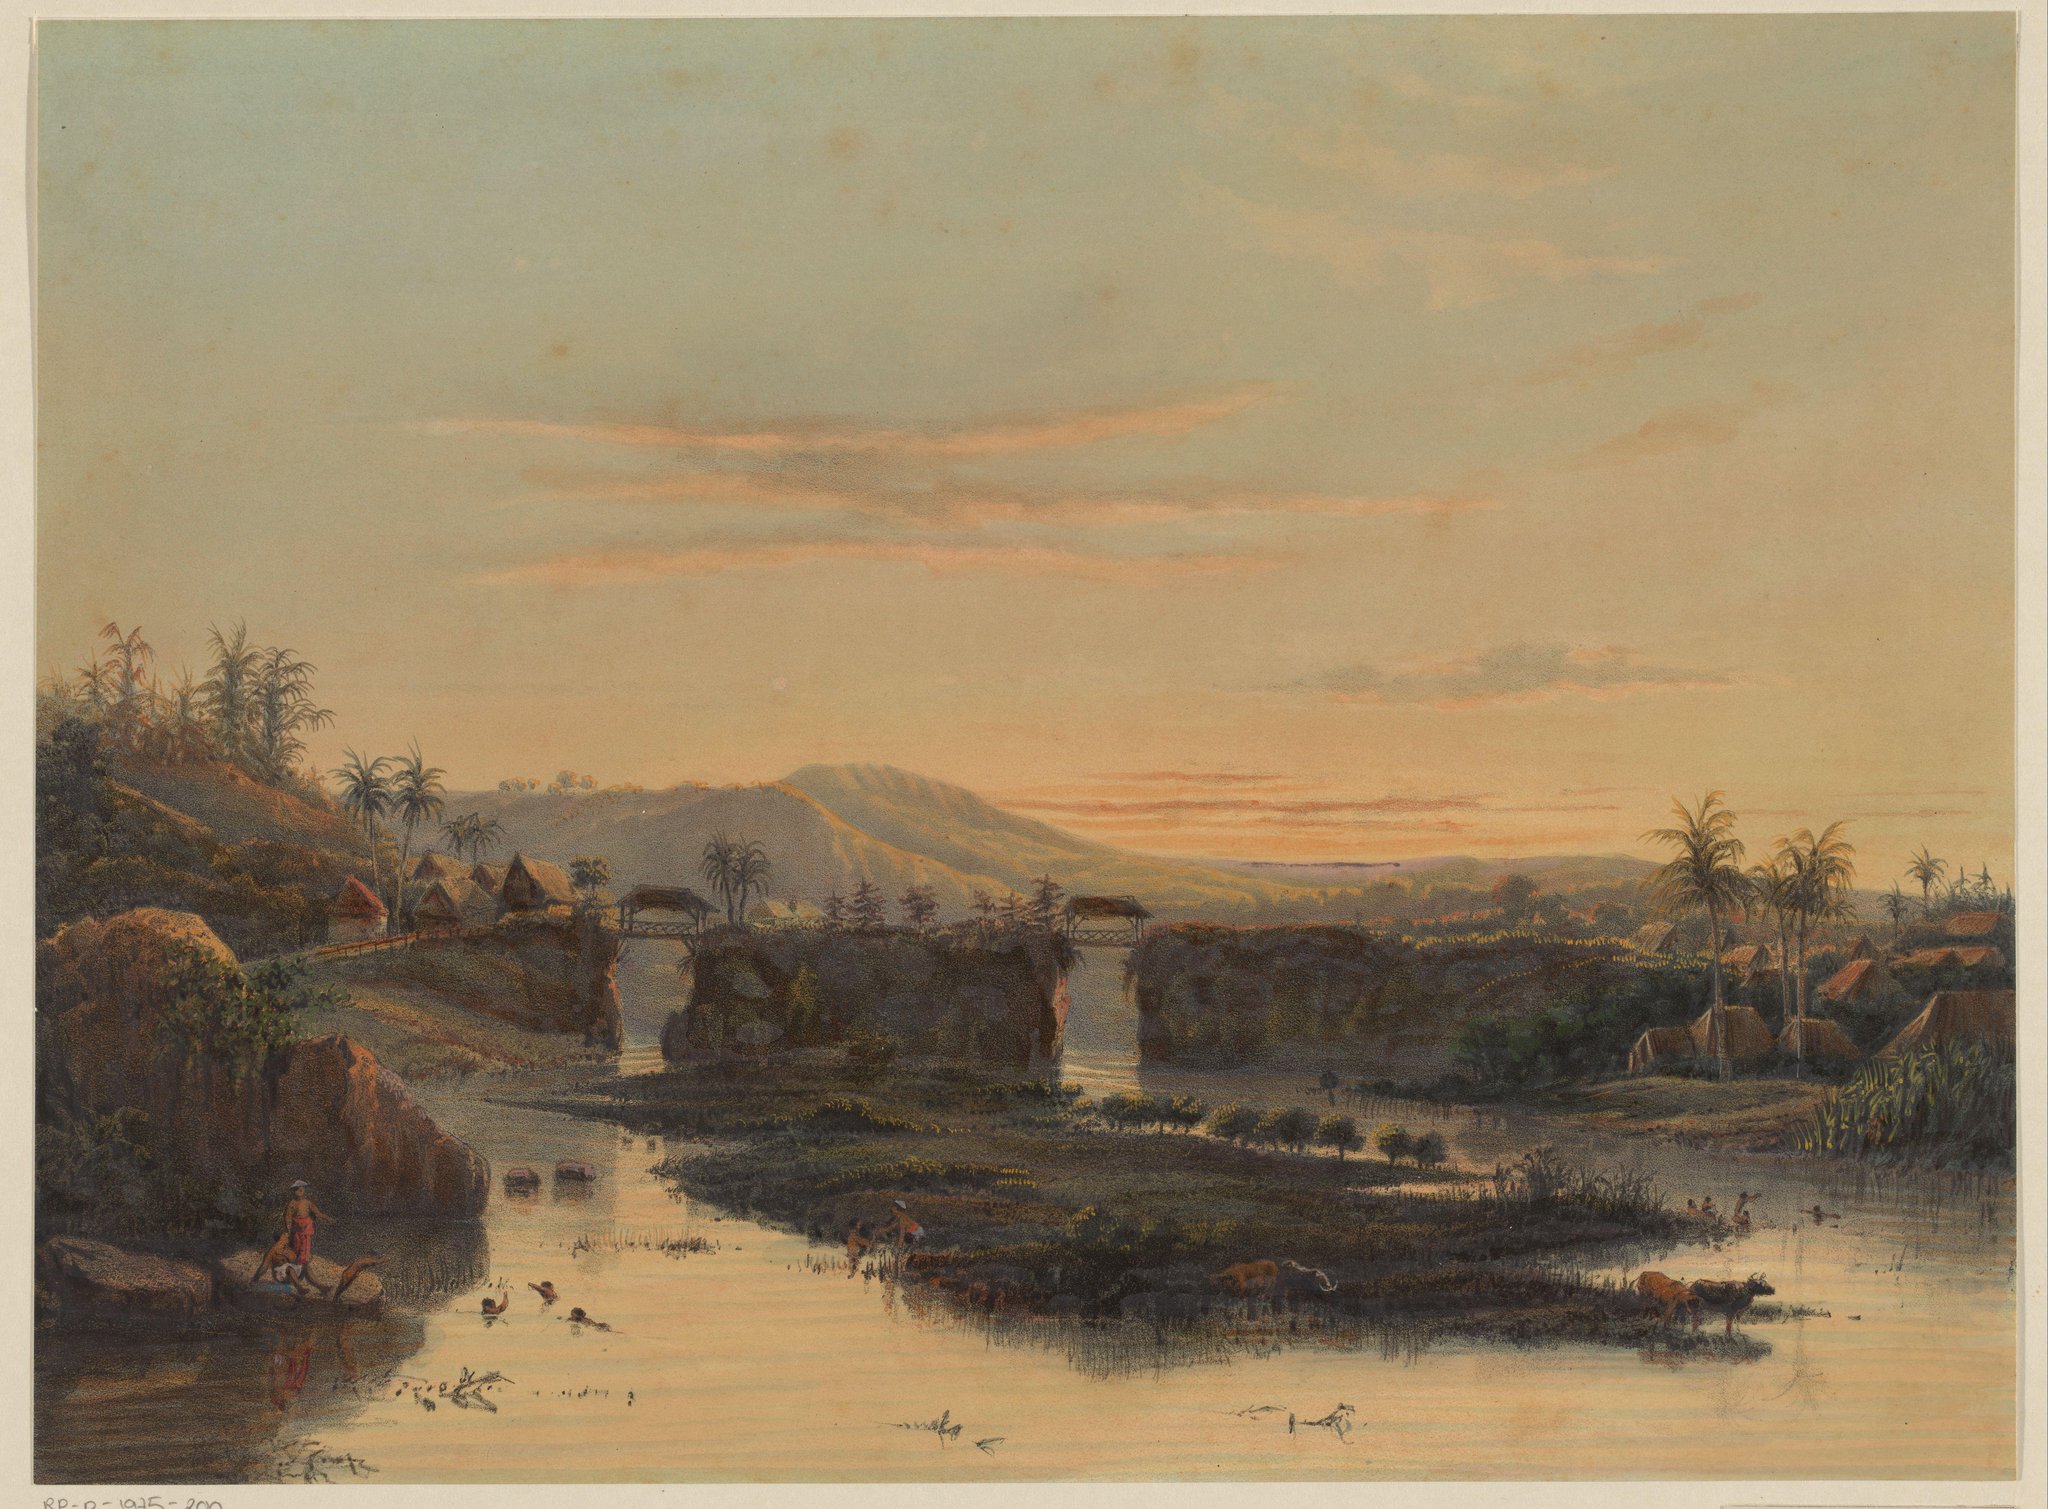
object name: print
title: Landschap in de Batavische ommelanden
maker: johan conrad greive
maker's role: draughtsman, painter, print maker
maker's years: 1837-1891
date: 1869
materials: paper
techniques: lithograph, hand coloring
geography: amsterdam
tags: landscapes in tropical and sub-tropical regions, java, batavia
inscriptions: collector's mark: Lugt 2228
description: De prent maakt deel uit van een omslag met een tekstblad en 24 losse prenten.